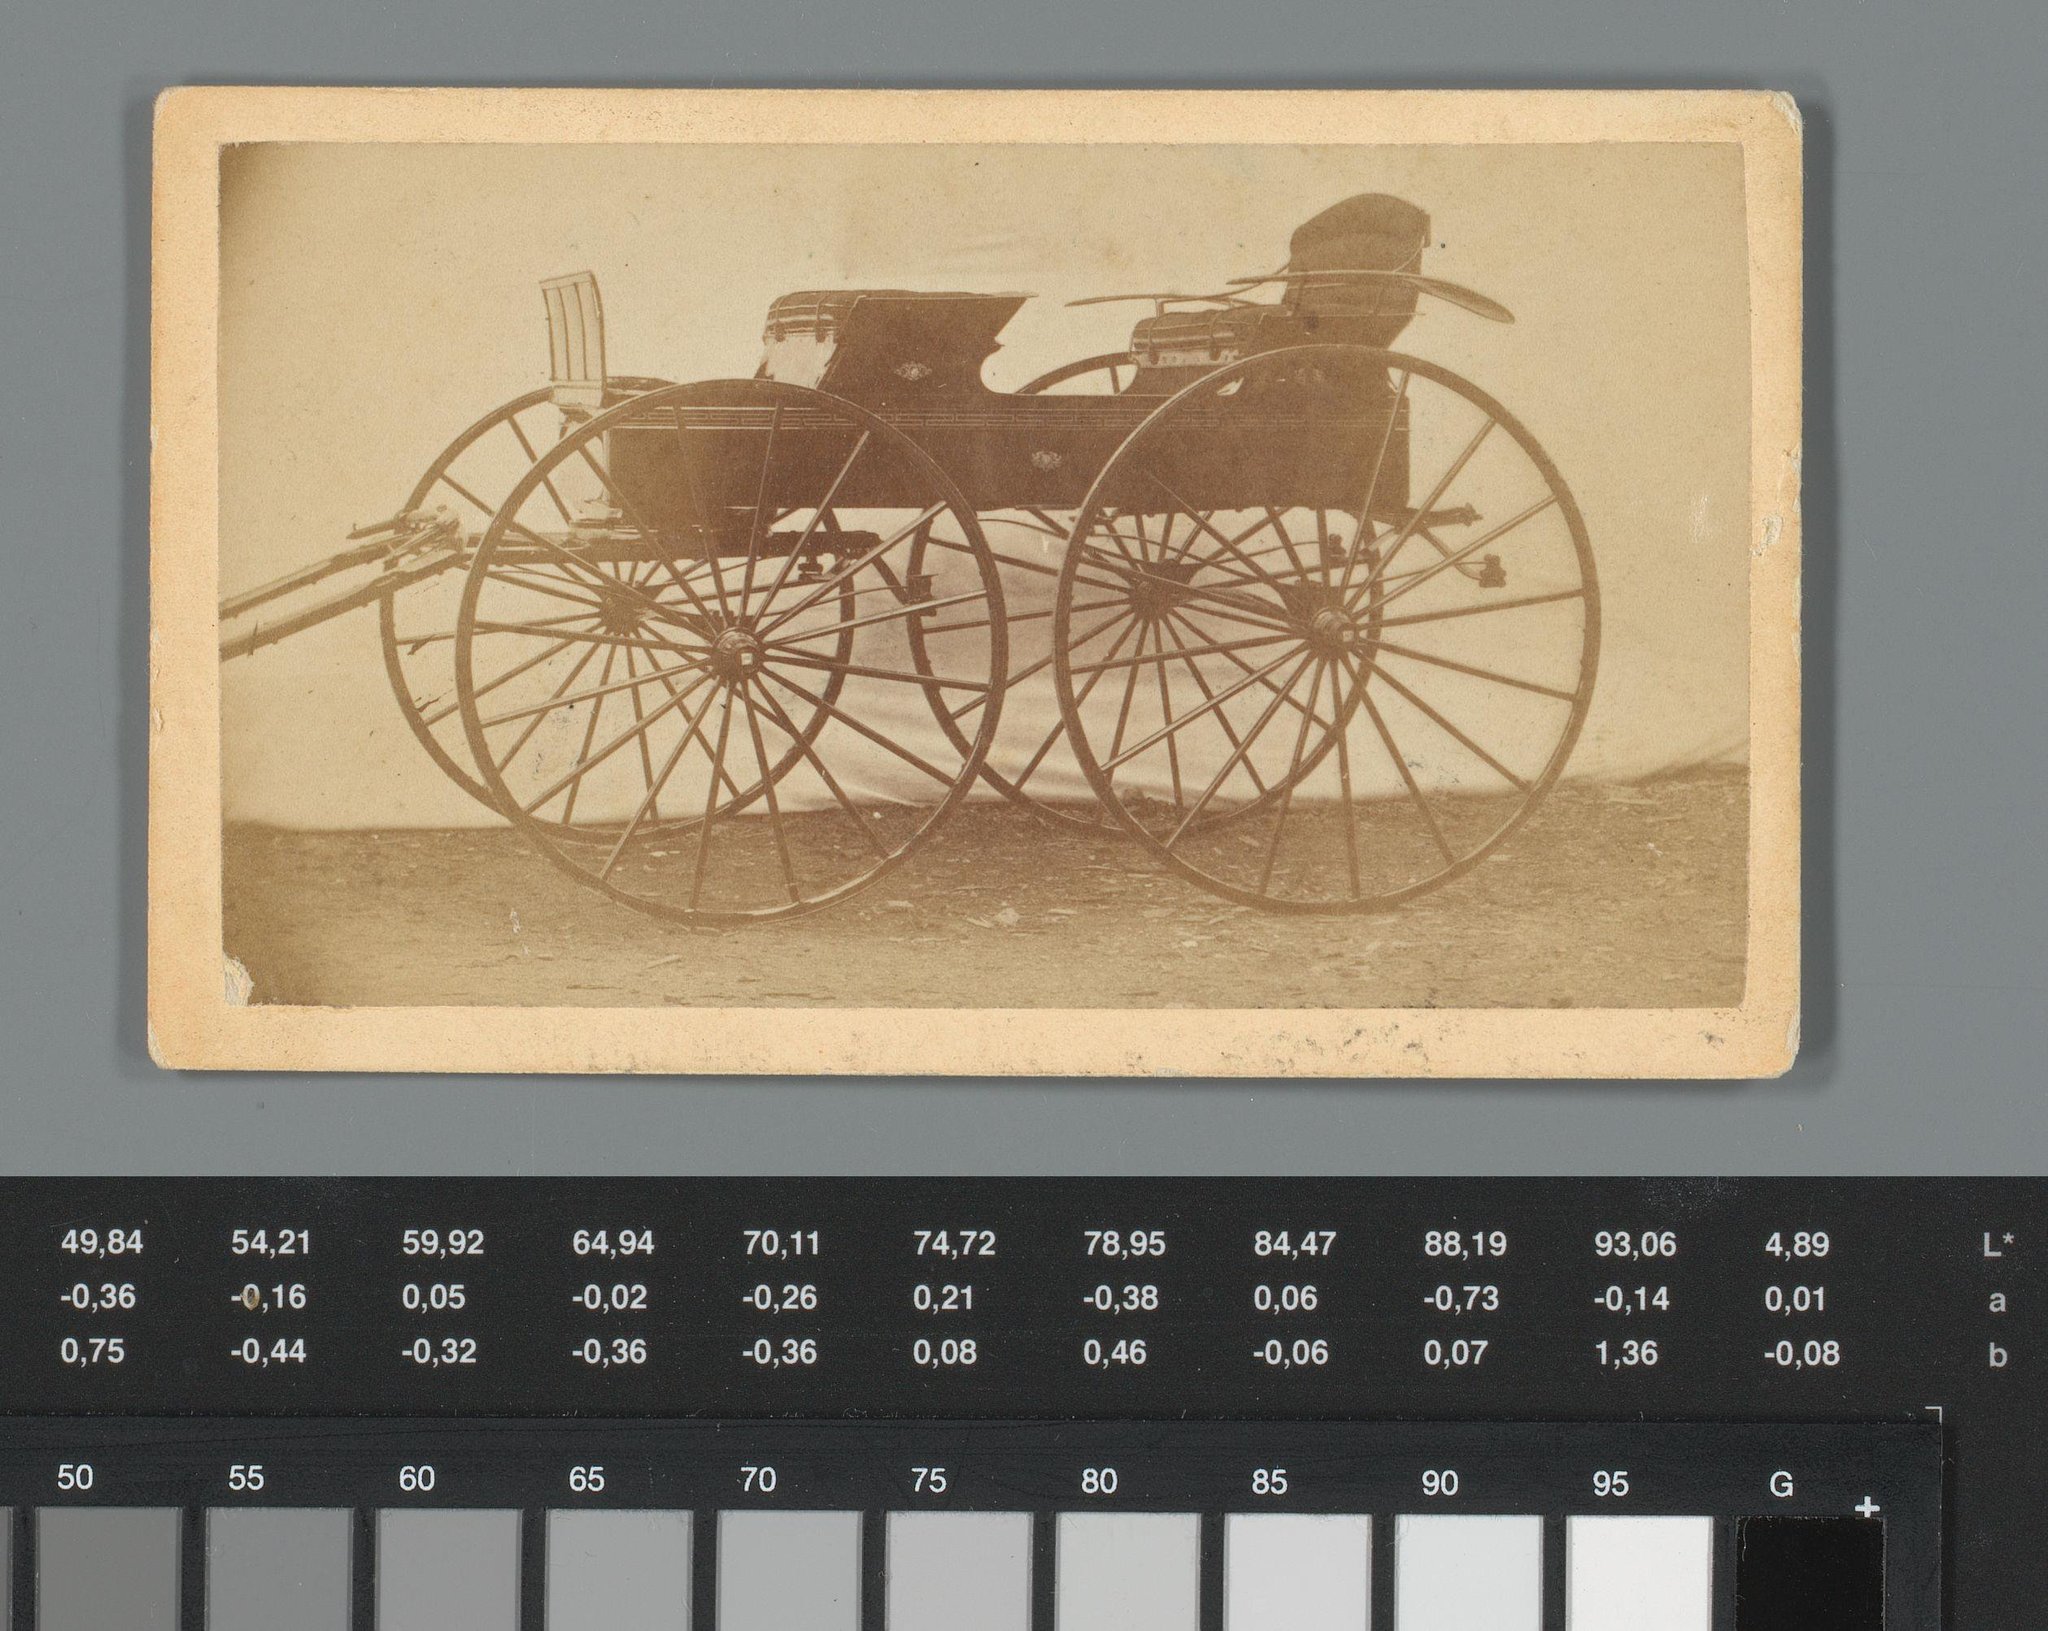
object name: carte de visite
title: Reclame voor een rijtuig van Fitzgerald & Kinne in Cortland, New York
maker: Anonymous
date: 1850-1915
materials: cardboard, photographic support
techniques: albumen print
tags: advertising, four-wheeled, animal-drawn vehicle, e.g.: cab, carriage, coach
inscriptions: inscription: ‘(...)’